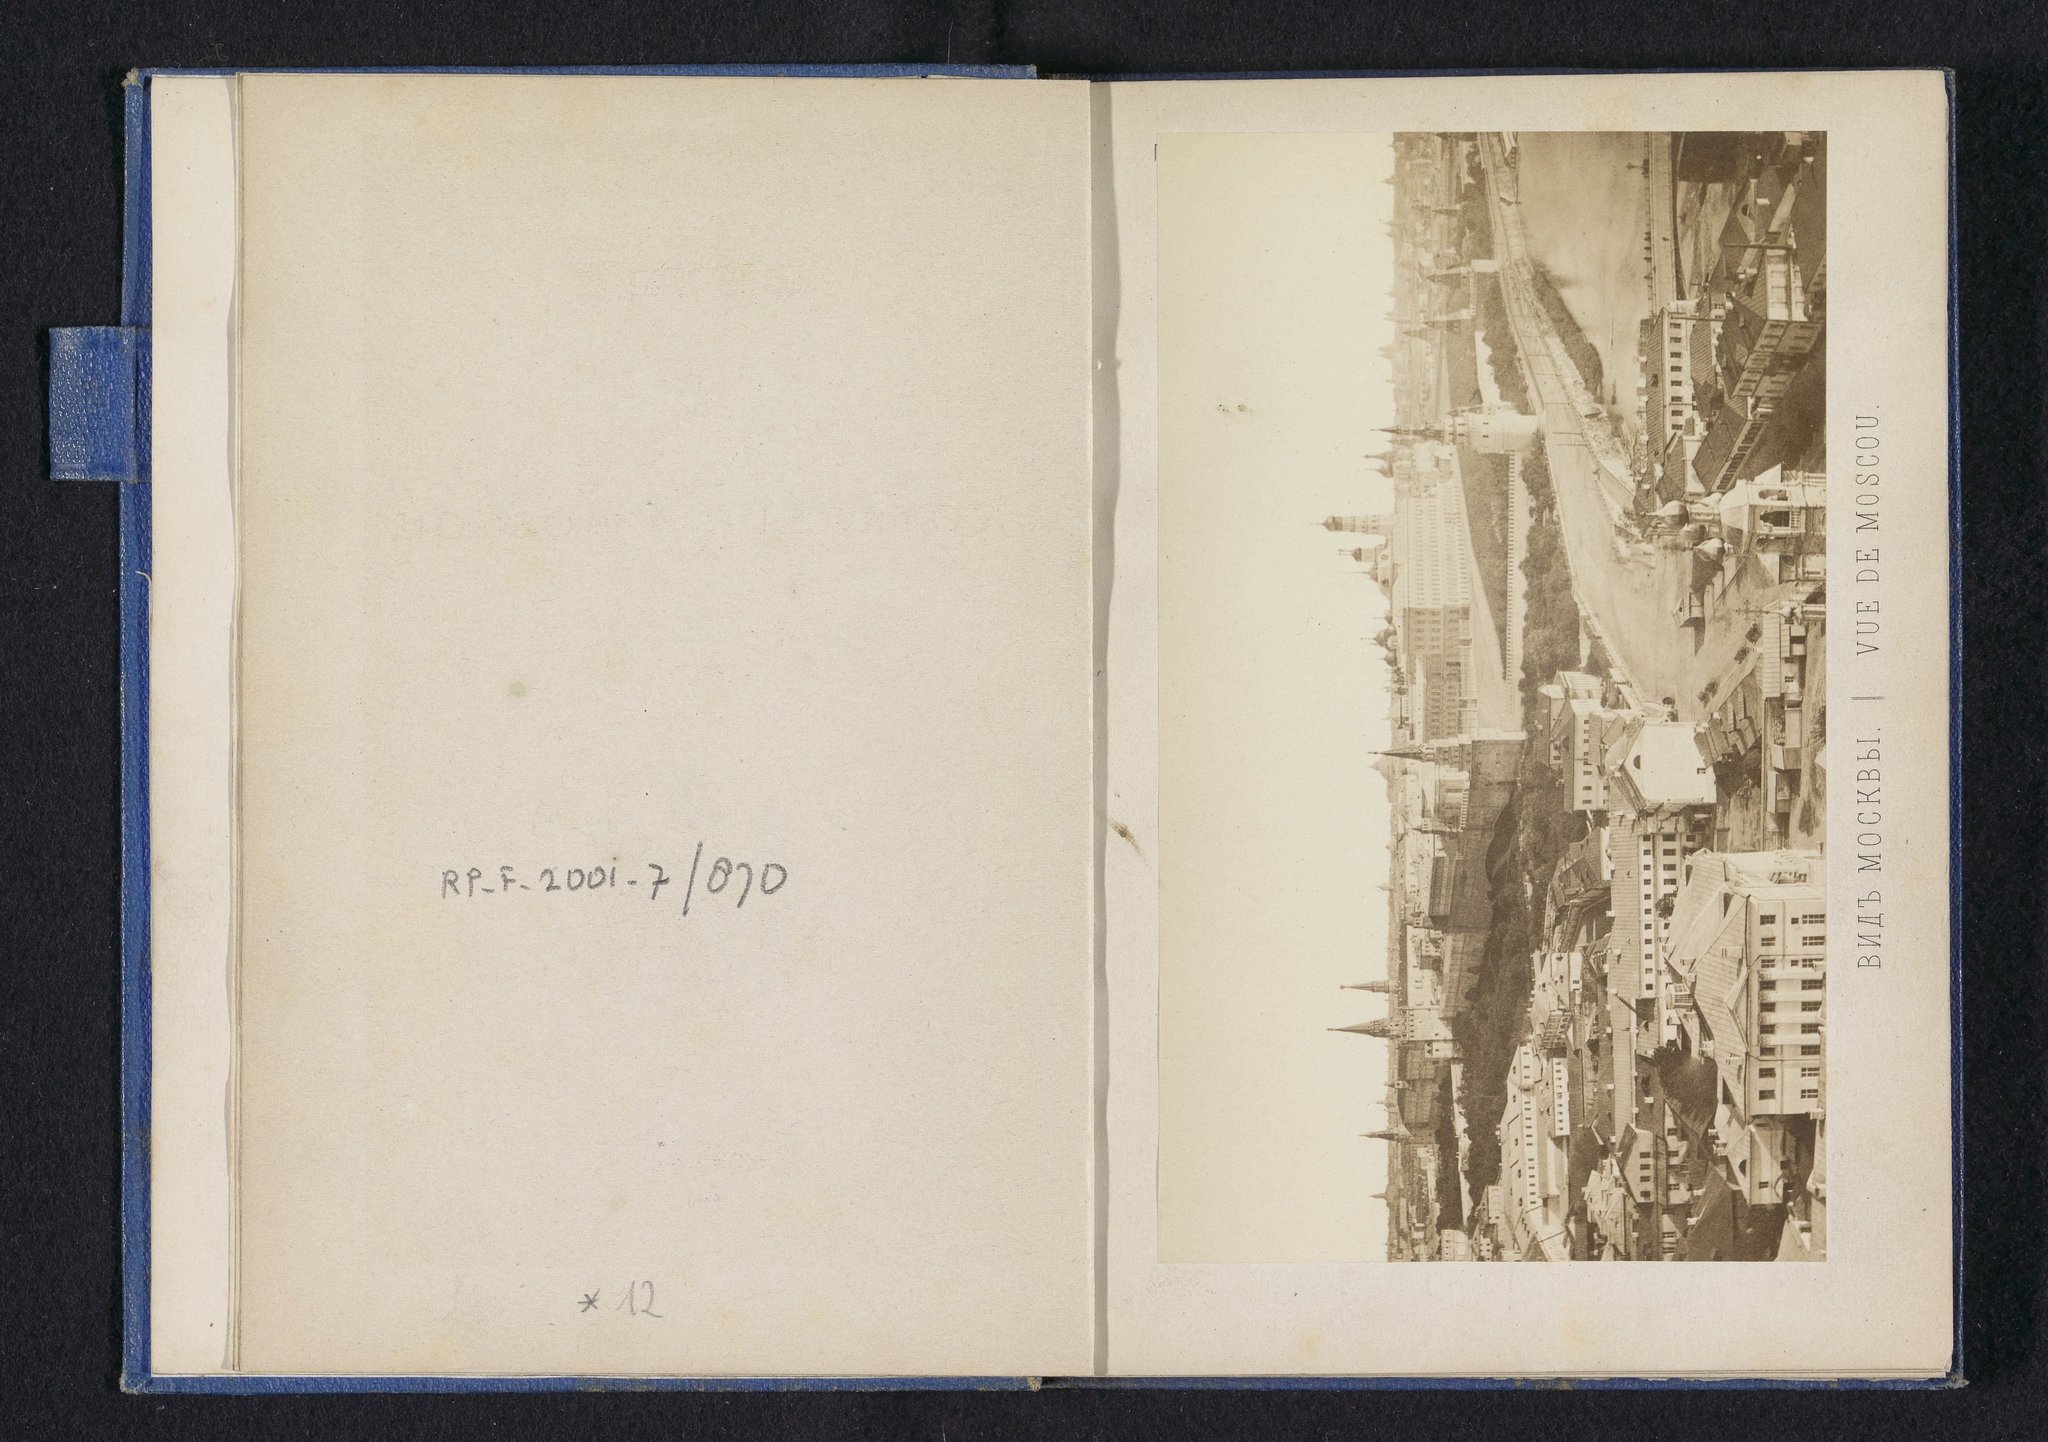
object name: page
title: Gezicht op Moskou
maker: Anonymous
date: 1865-1870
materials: photographic support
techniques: albumen print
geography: moscow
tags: prospect of city, town panorama, silhouette of city